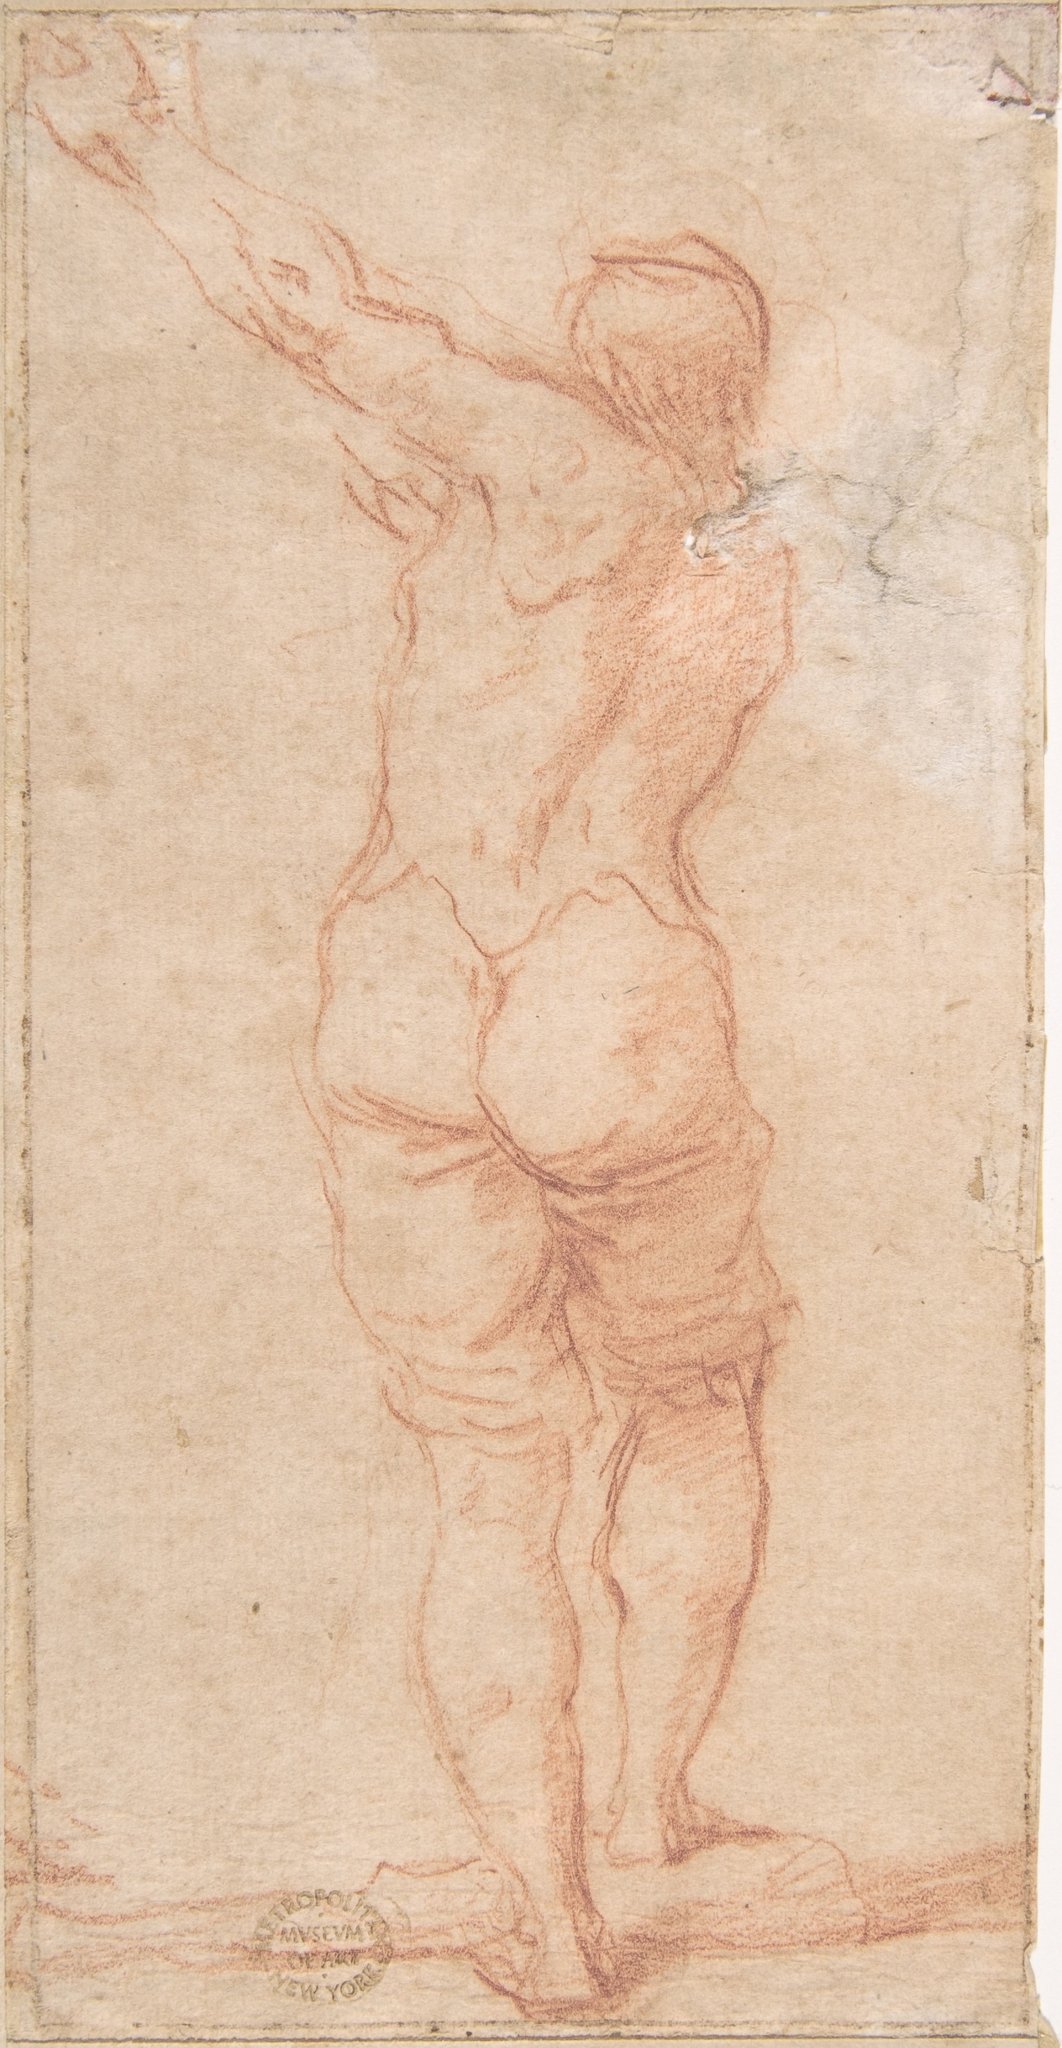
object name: drawing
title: Male Figure with Arms Raised to the Left Seen From the Rear (recto); Male Figures with Arms Raised to the Left (front view of figure on recto) (verso)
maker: anonymous, italian, bolognese, 17th century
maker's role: artist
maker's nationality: italian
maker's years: 1600-1700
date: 1601-1700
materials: chalk, ink, paper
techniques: pen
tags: male nudes